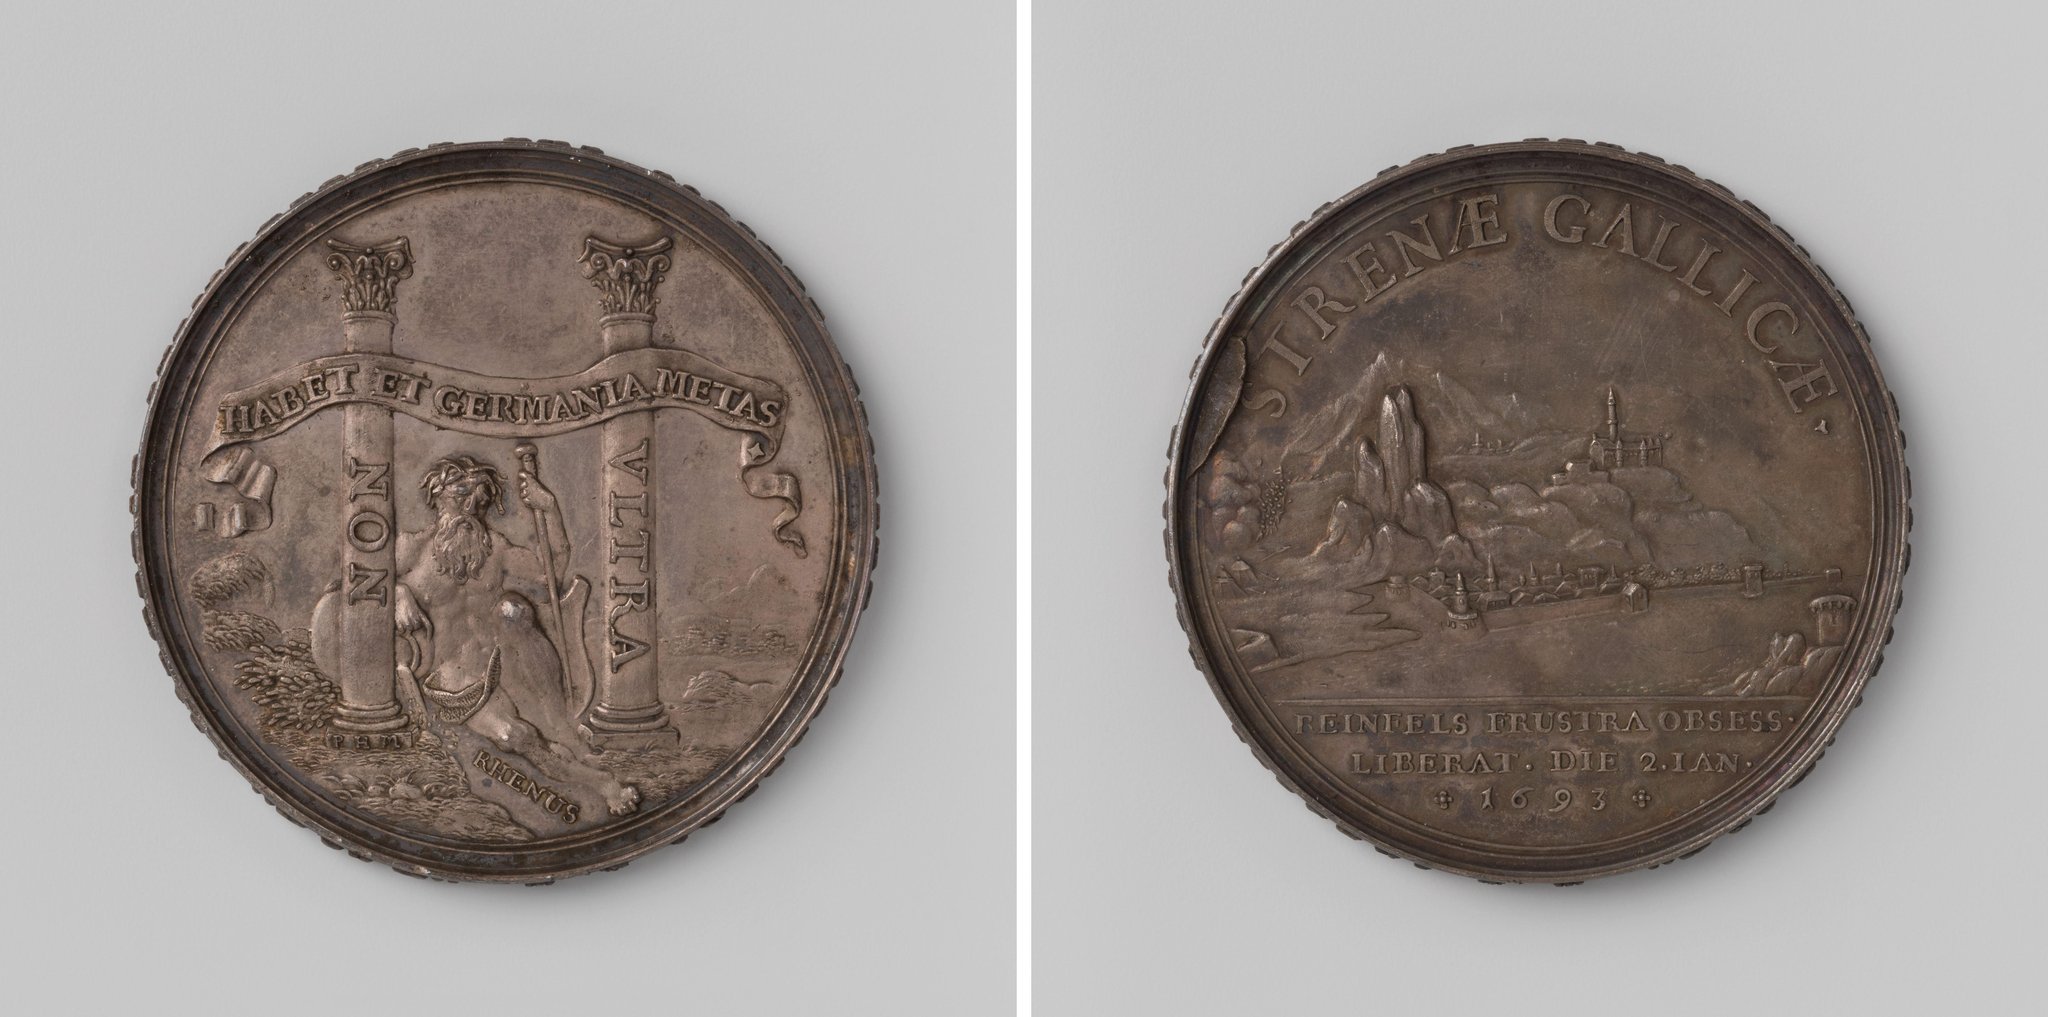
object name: history medal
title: Rheinfels ontzet door de Landgraaf van Hessen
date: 1693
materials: silver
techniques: striking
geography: nuremberg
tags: frederik i (koning van zweden)